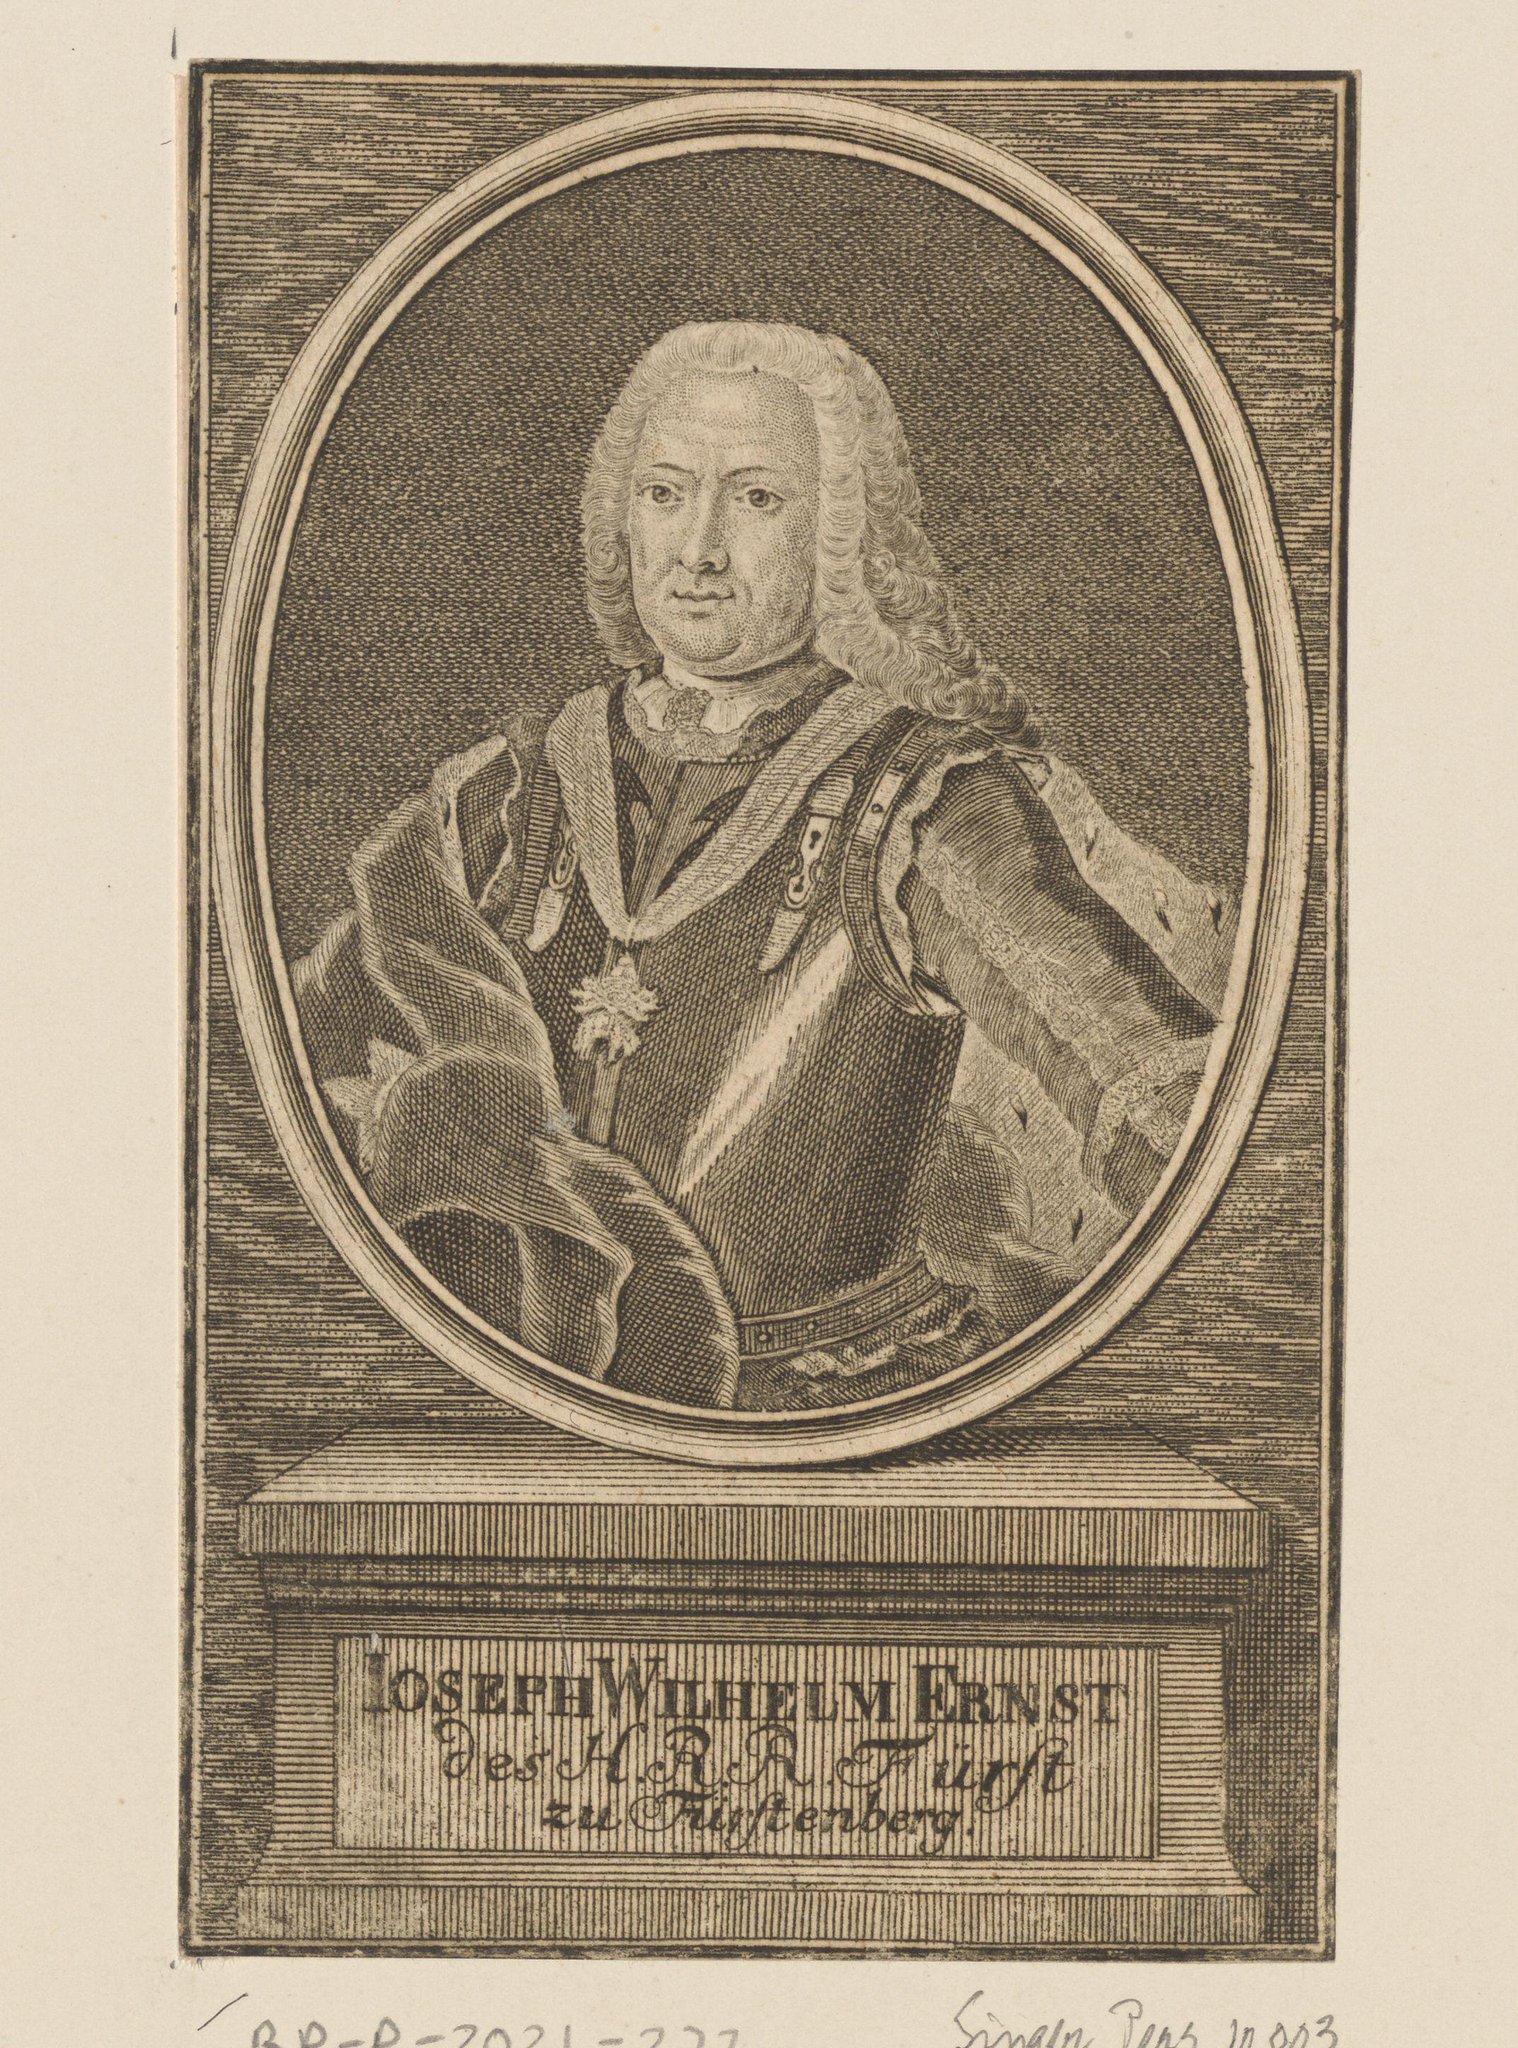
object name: print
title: Portret van Joseph zu Fürstenberg-Stühlingen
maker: Anonymous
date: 1744-1799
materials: paper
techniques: etching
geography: germany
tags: augsburg, ornament ~ medallion, armour, historical persons, knighthood order of the golden fleece - insignia of a knighthood order, e.g.: badge, chain (with name of order)